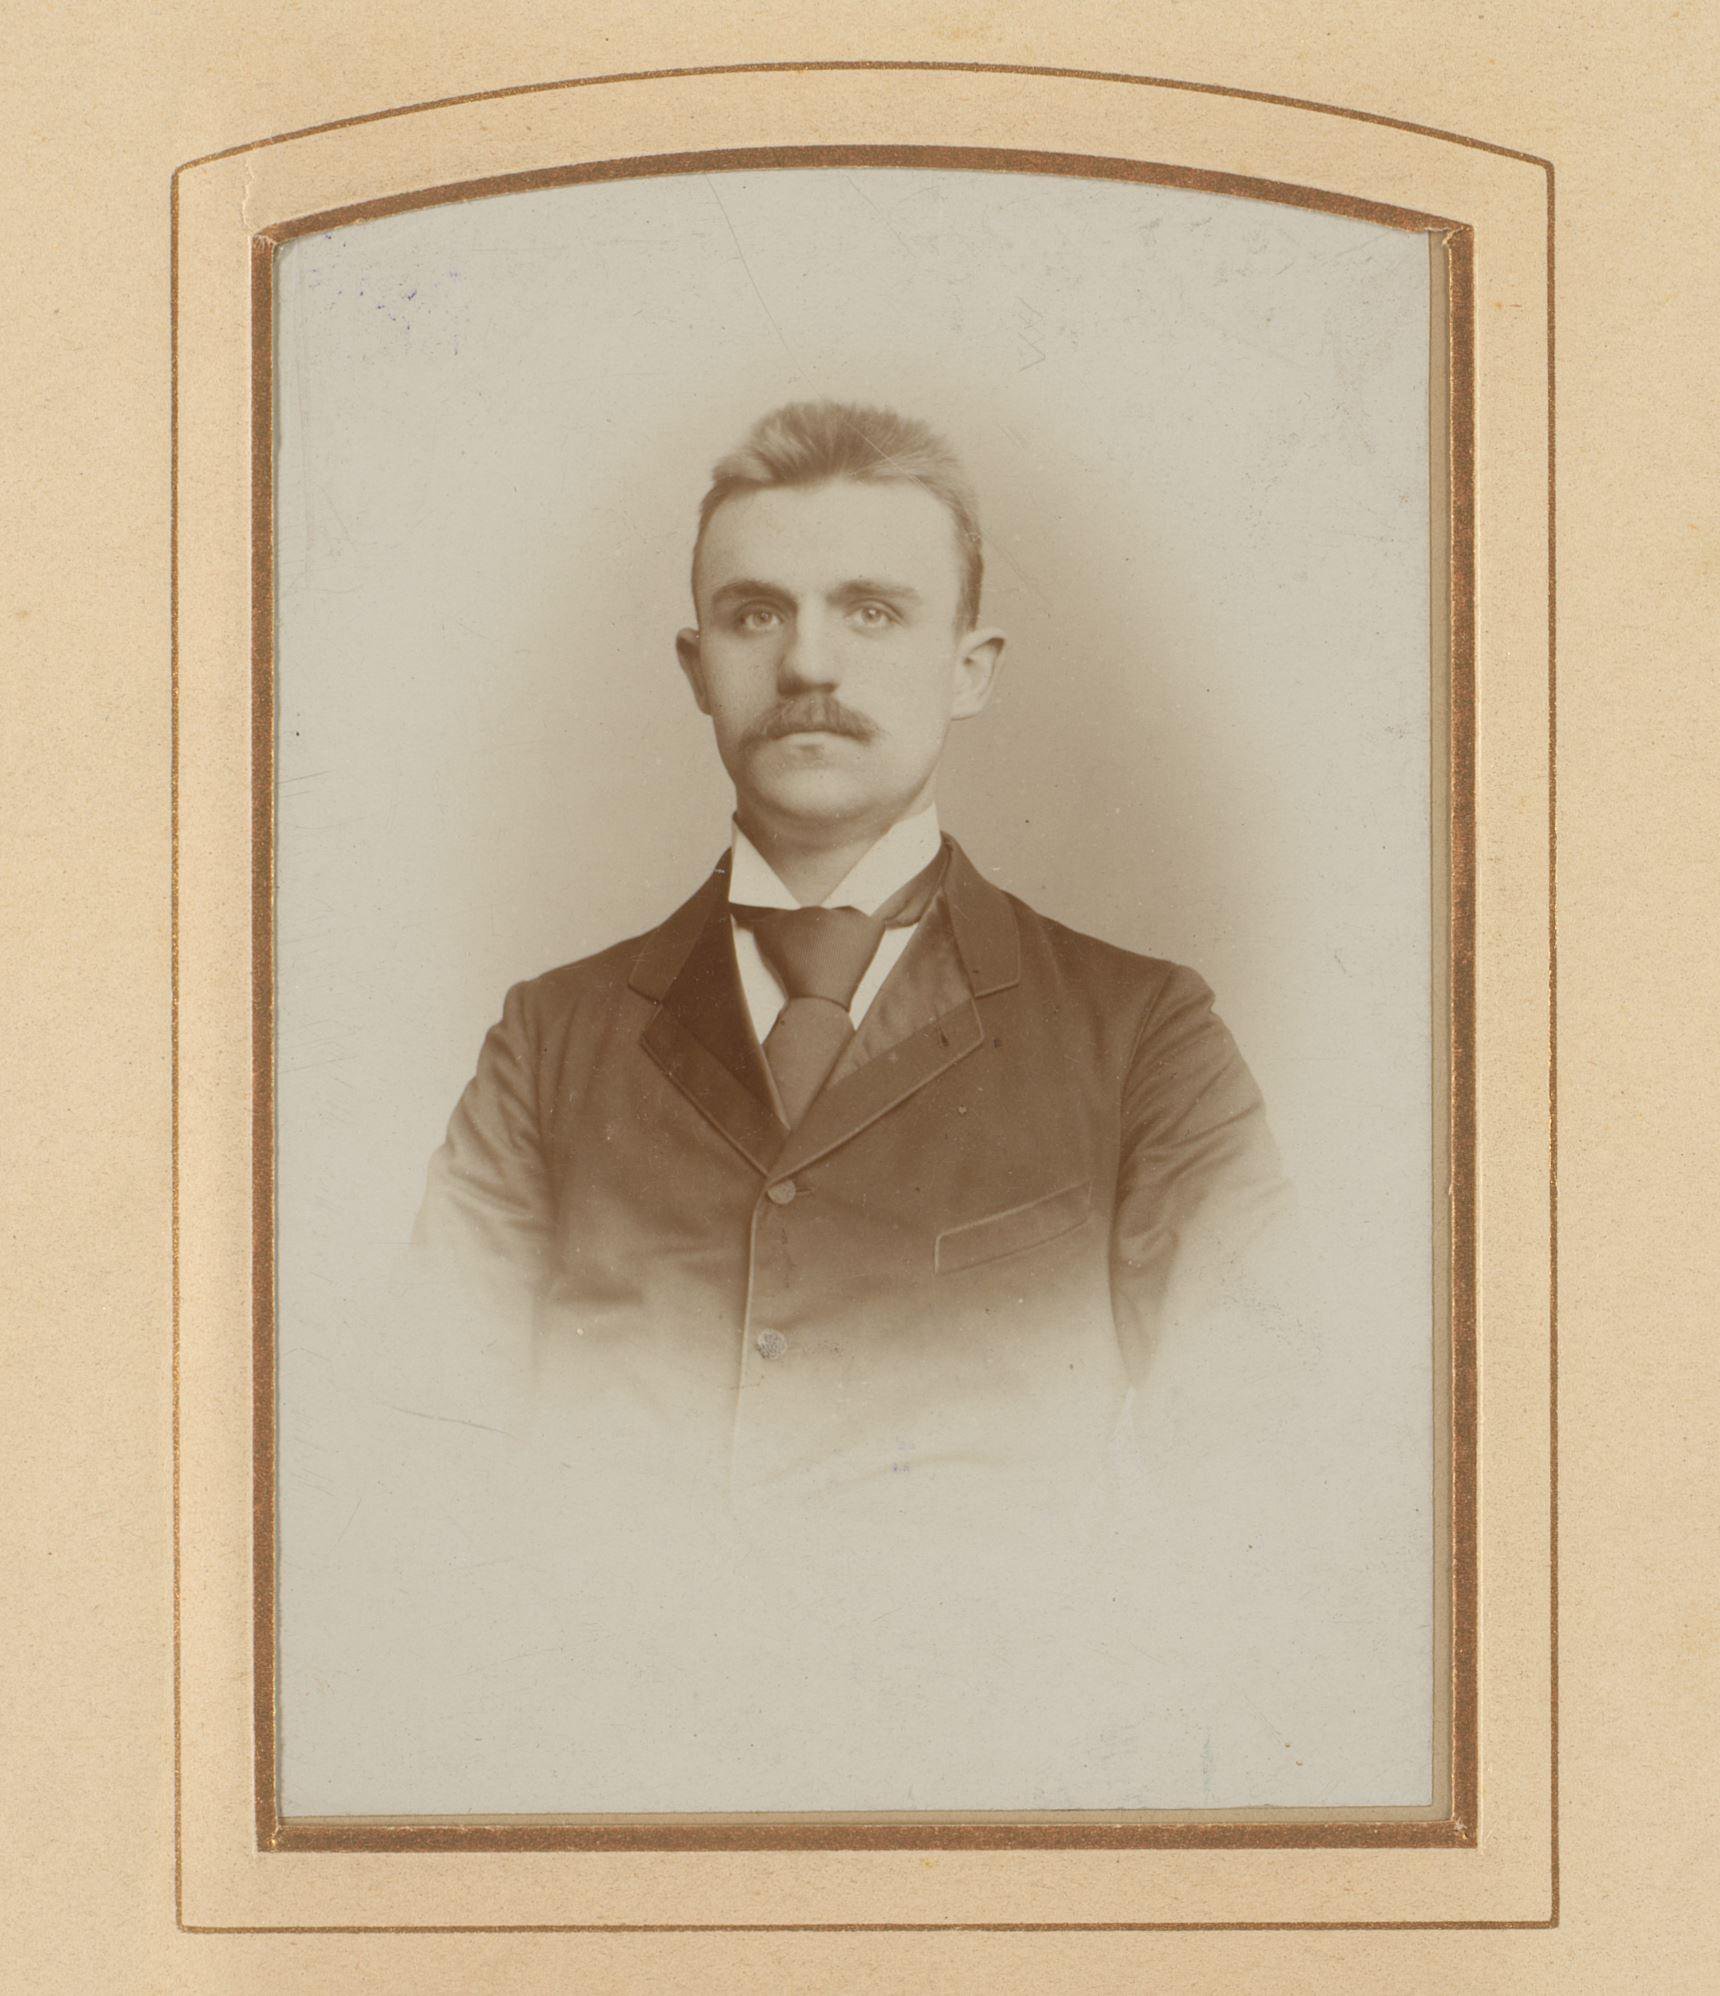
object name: photograph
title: Portret van een man met snor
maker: Anonymous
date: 1880-1900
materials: cardboard, photographic support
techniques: collodion silver print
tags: moustache, historical persons